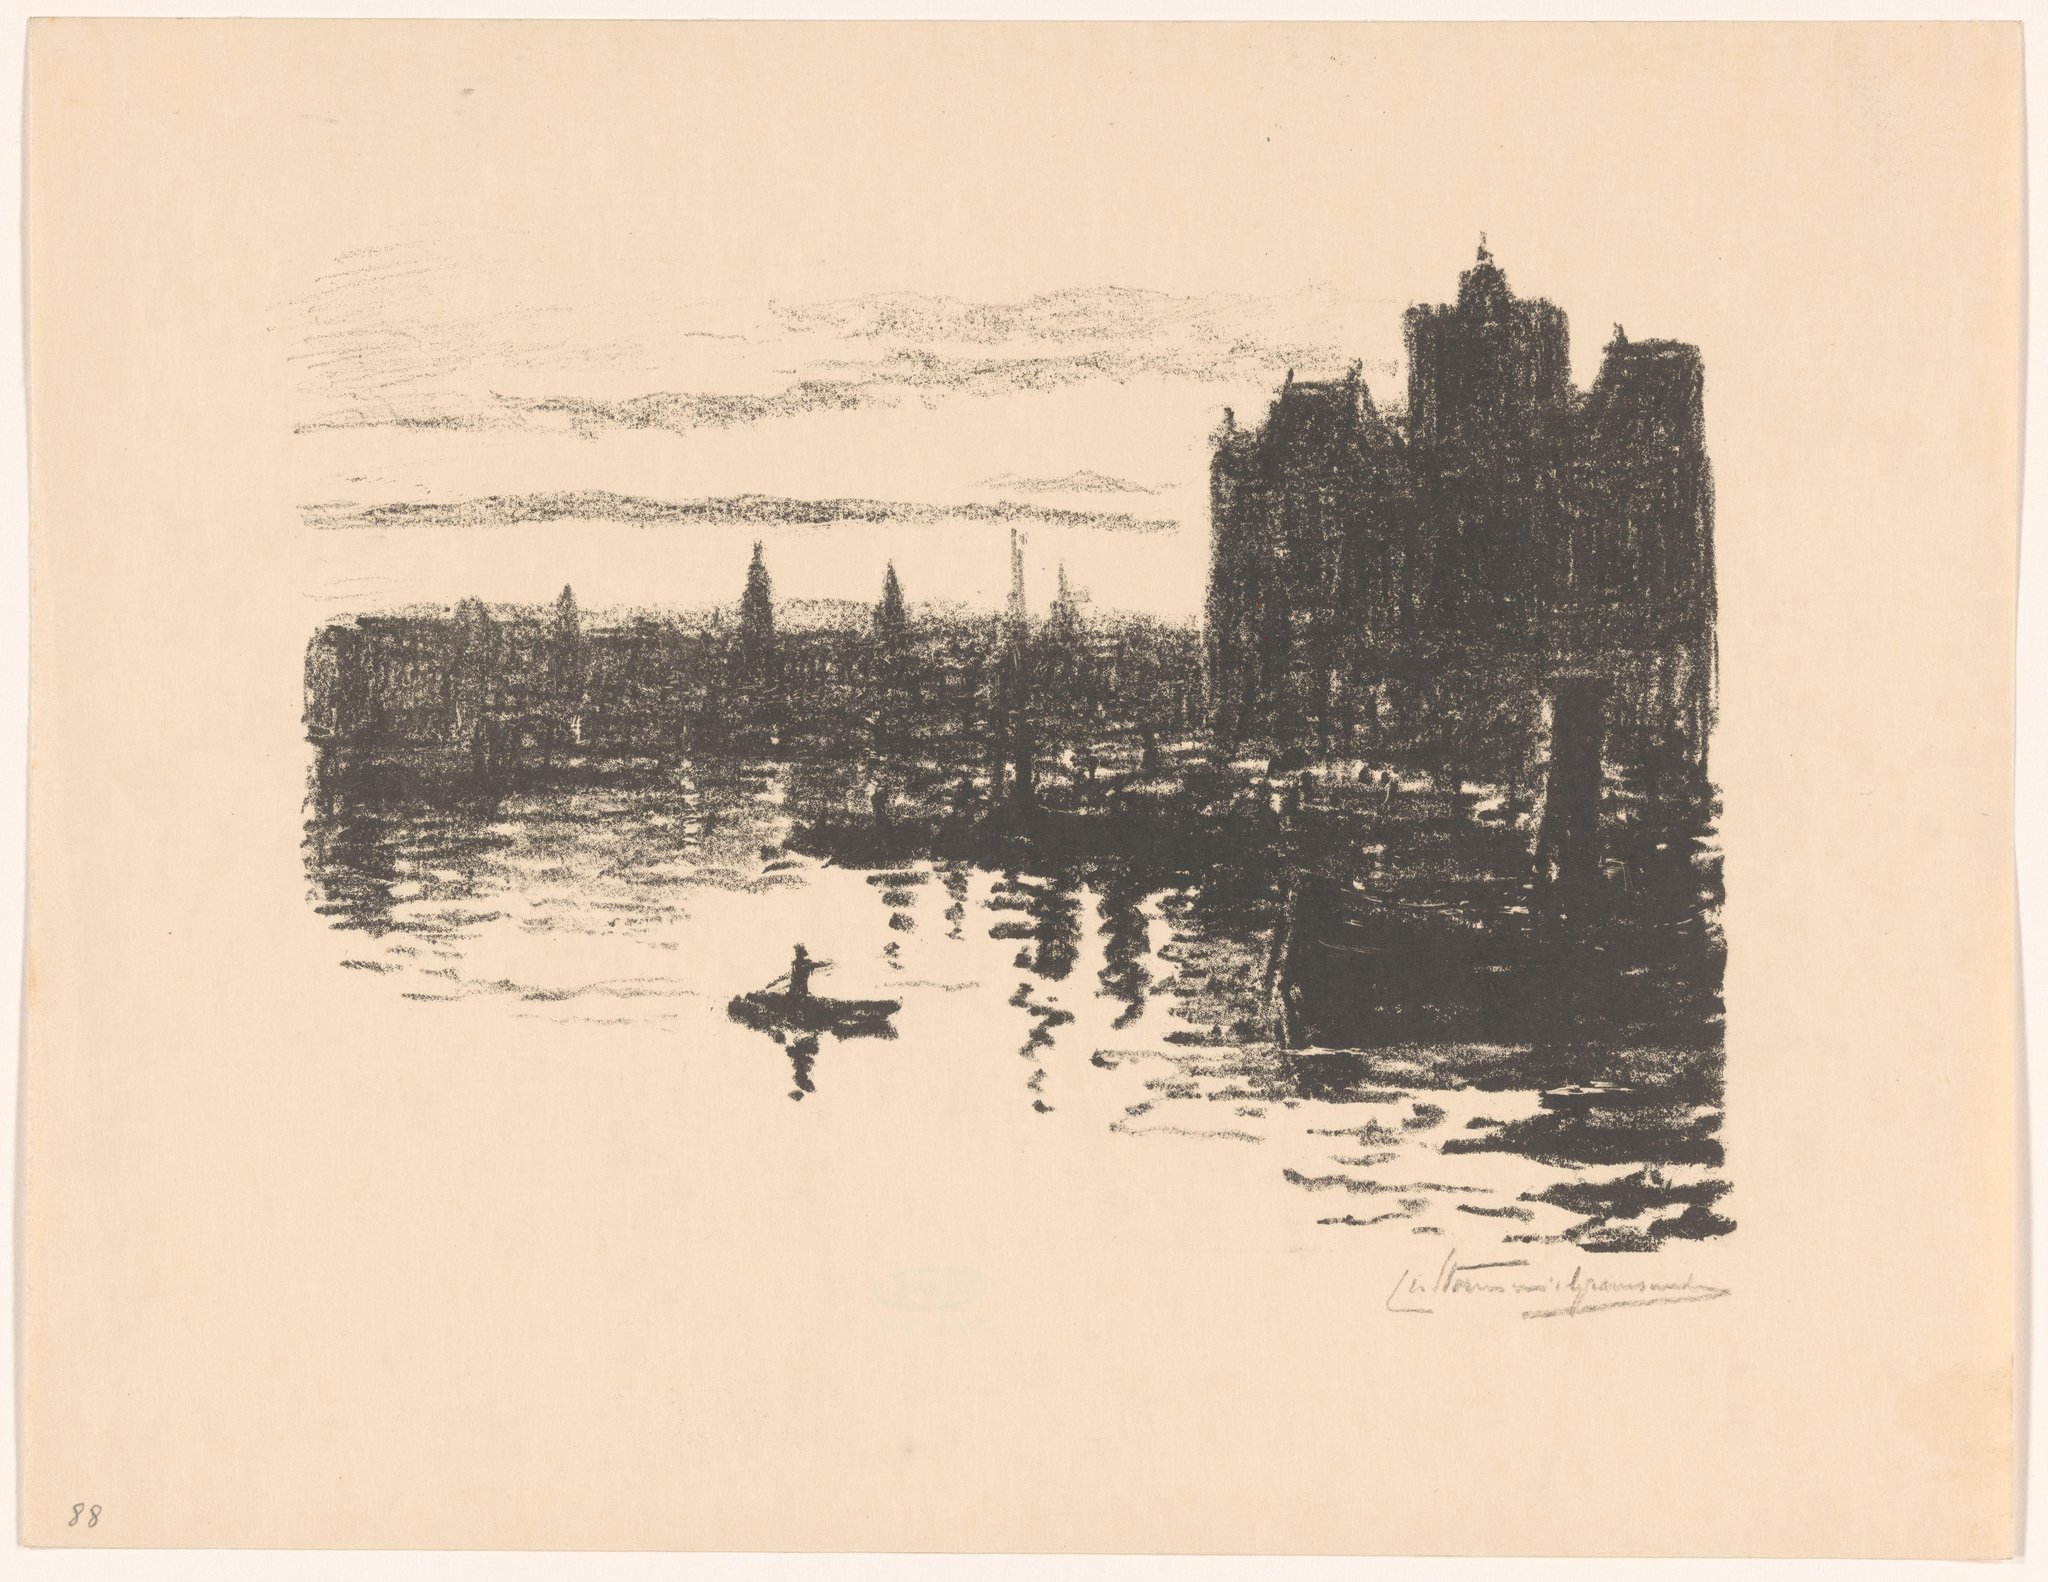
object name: print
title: Geldersekade in Amsterdam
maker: carel nicolaas storm van s-gravesande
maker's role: draughtsman, print maker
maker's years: 1841-1924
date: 1851-1924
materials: paper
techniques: lithograph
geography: netherlands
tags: canals, waters (in city) (+ city(-scape) with figures, staffage)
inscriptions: collector's mark: Lugt 2228, number: ‘88’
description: Mogelijk vermeld in: Storm van 's-Gravesande, Charles. Catalogue des eaux-fortes et lithographies. New York: s.n., 1903, of in een onbekende latere uitgave van het manuscript. Vermoedelijk vermeld als catalogusnummer 88.